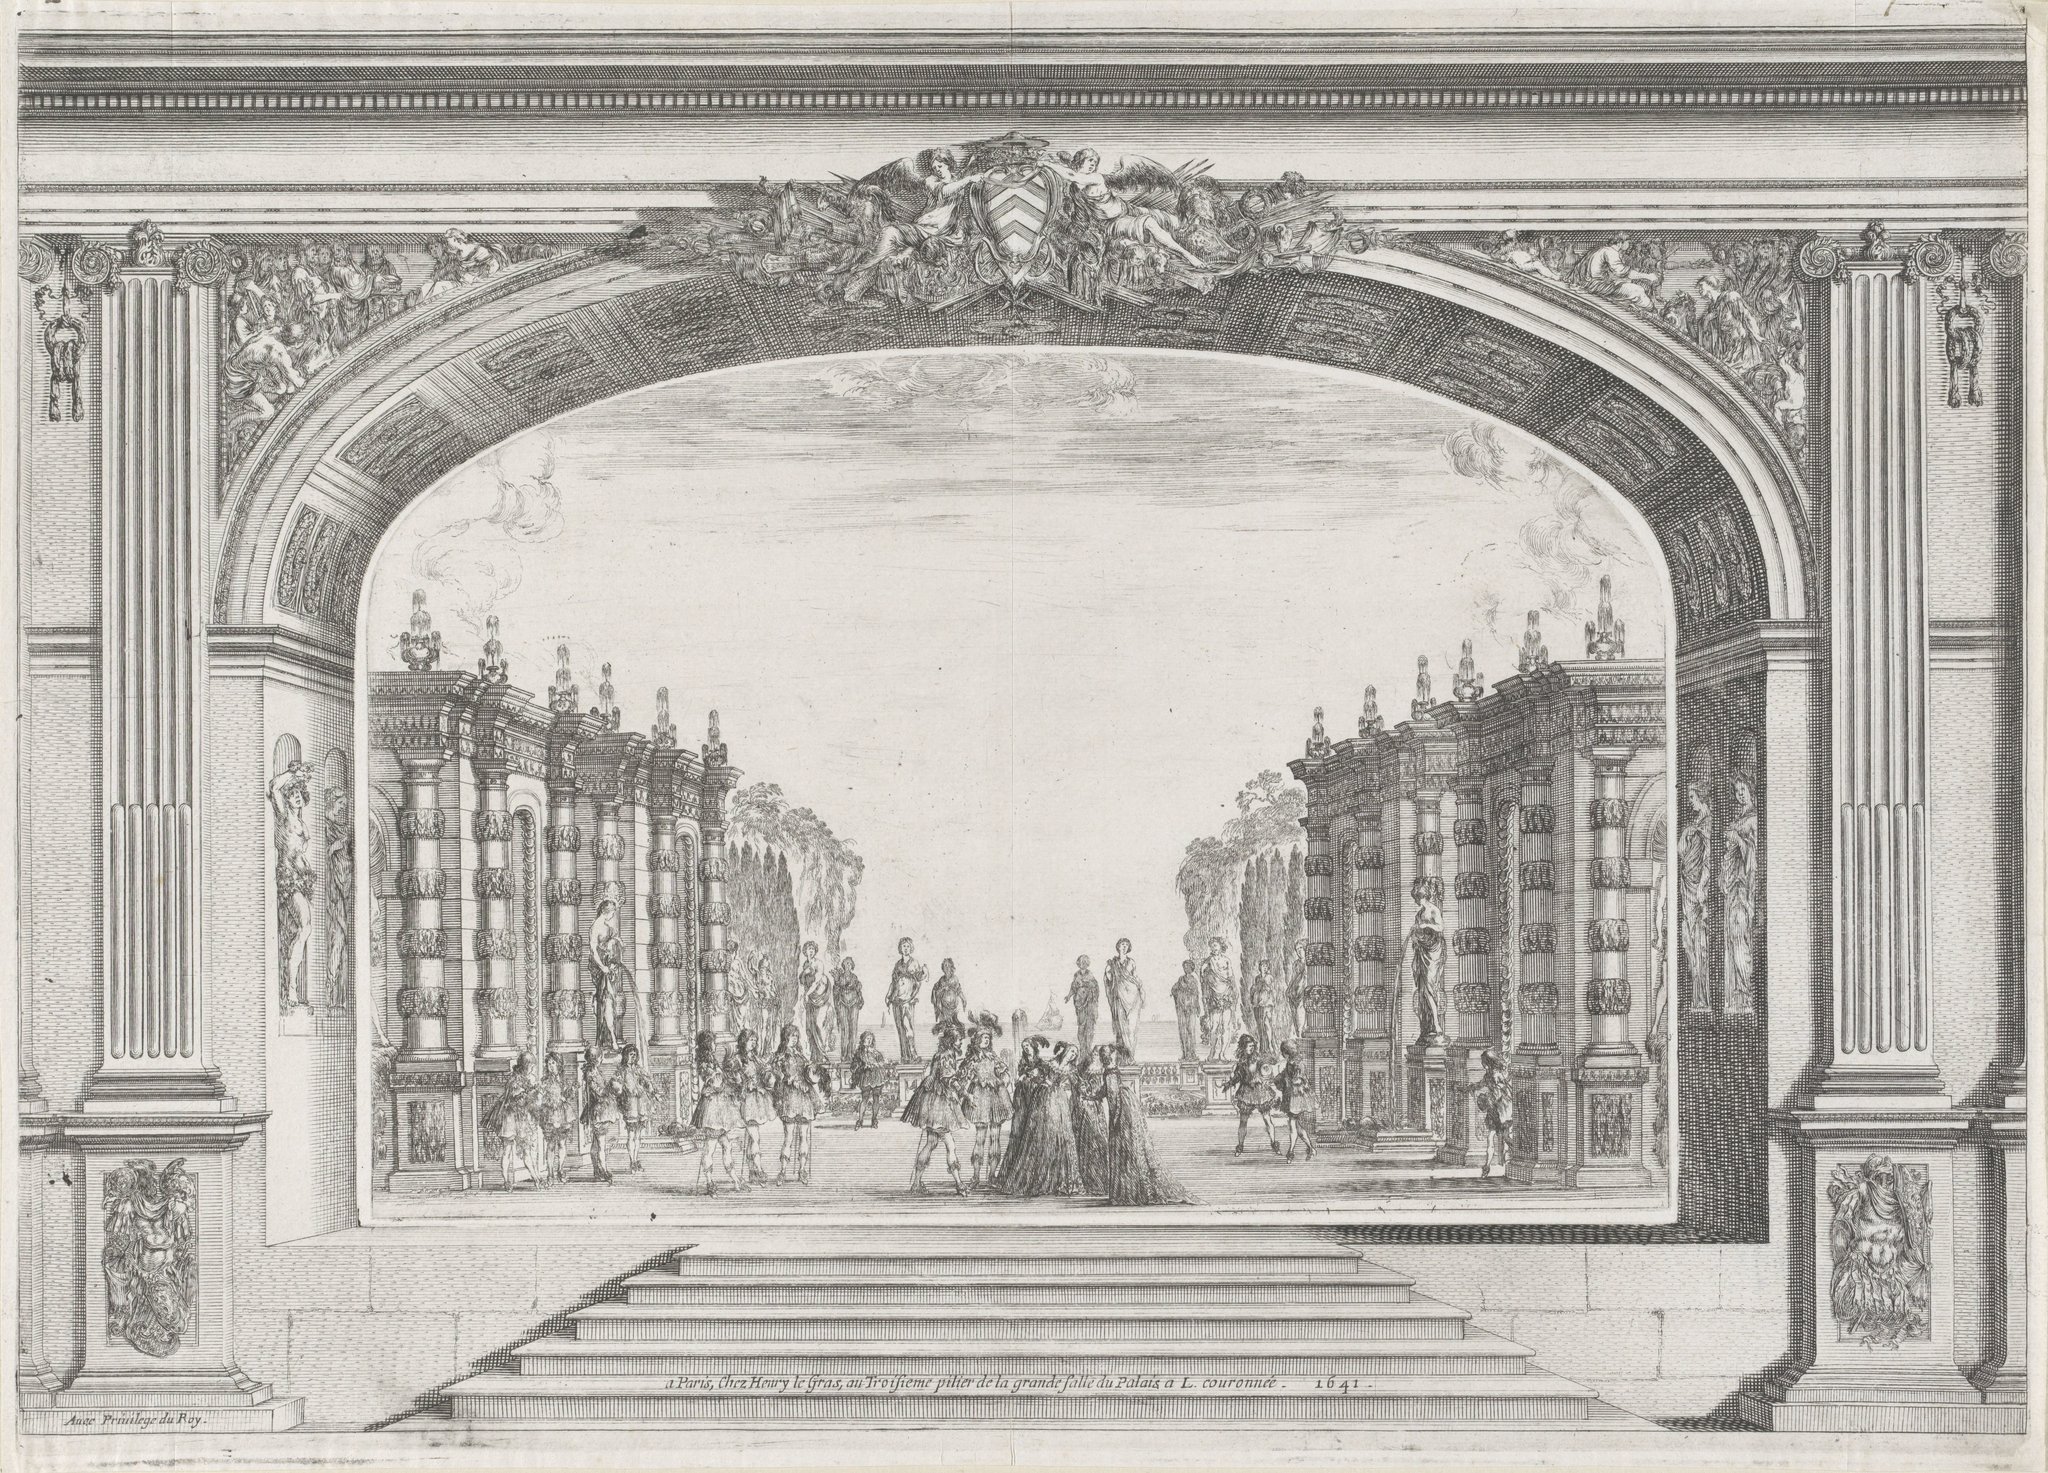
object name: ornament print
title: Opvoering van 'Mirame' in de grote zaal van het paleis van de kardinaal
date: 1641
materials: paper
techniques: etching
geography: france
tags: set, scenery ~ stage, actor (on the stage)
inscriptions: collector's mark: Lugt 240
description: Zicht op een podium waar de vijfde akte uit 'Mirame' met zeventien acteurs wordt opgevoerd. Het decor is een tuin met beelden aan zee. De omlijsting om het podium heeft de vorm van een Romeinse triomfboog.